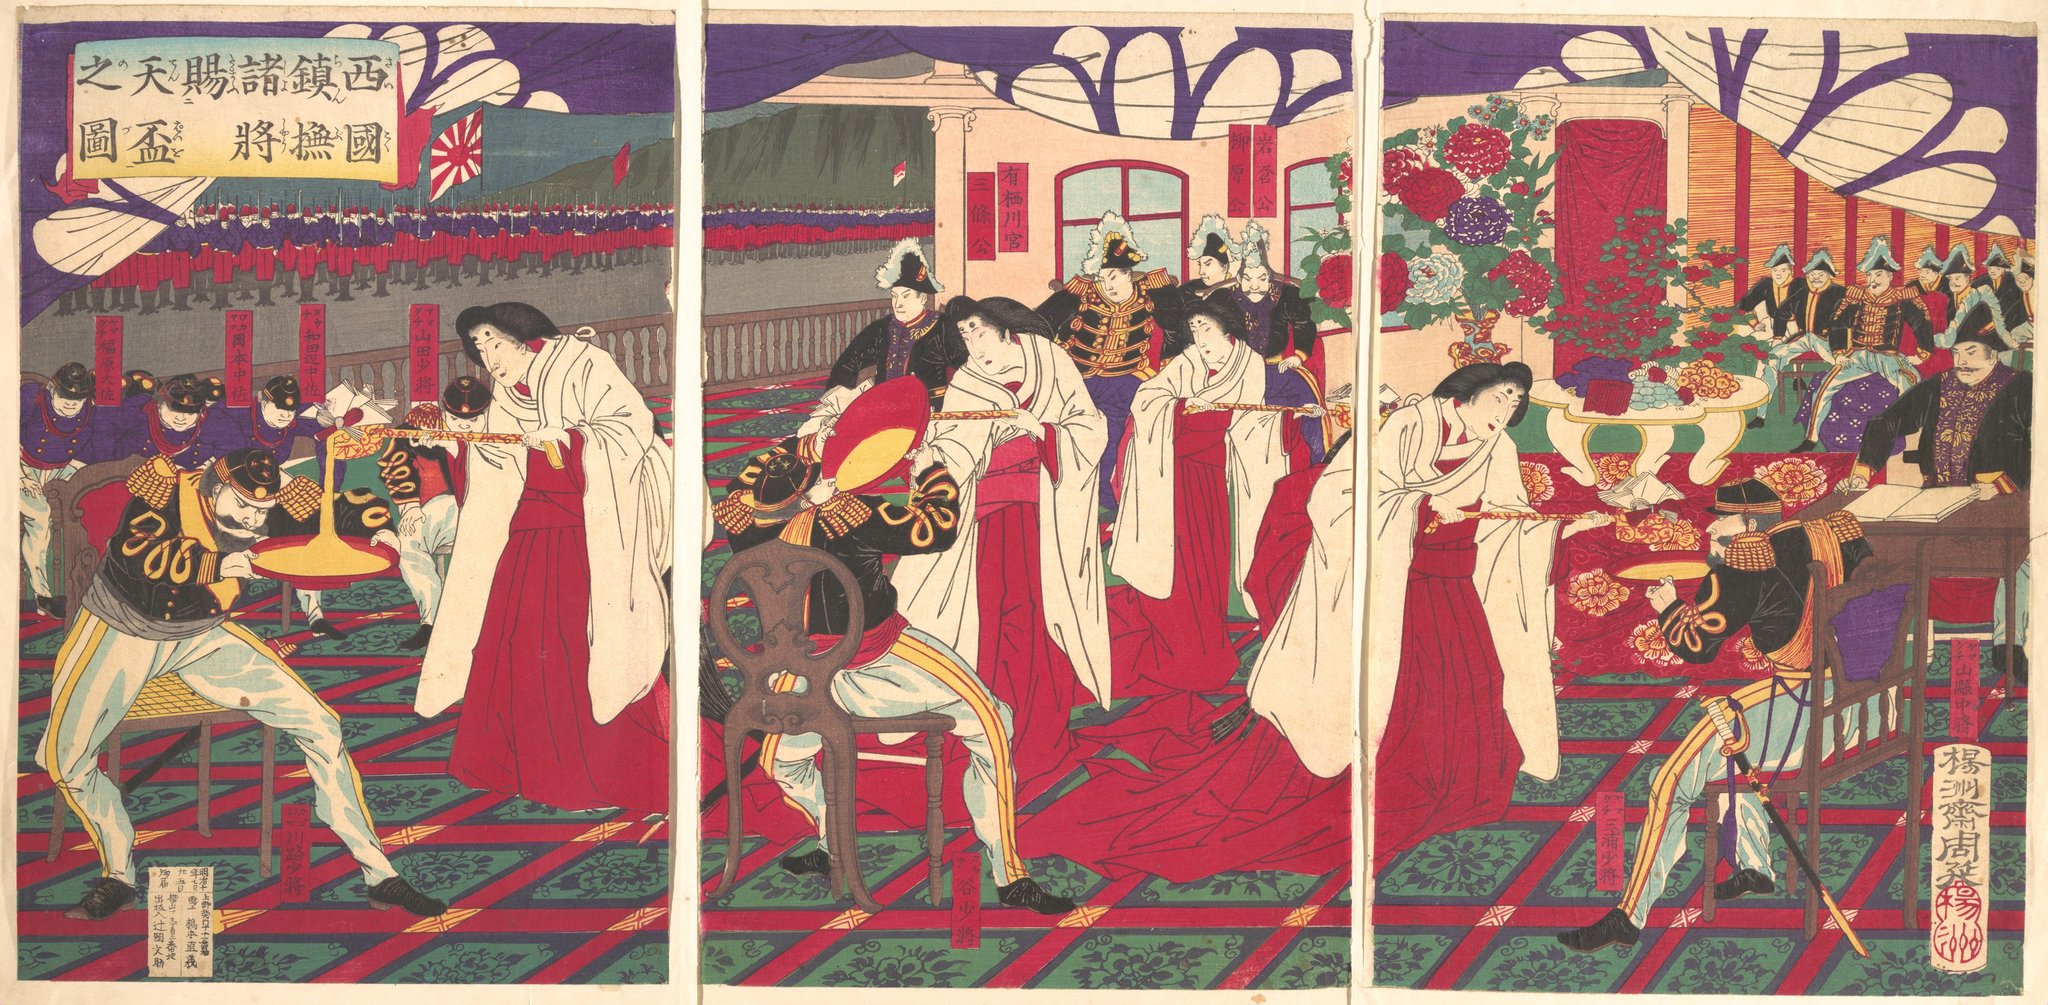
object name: woodblock print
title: Illustration of the Commanders who Pacified Western Japan, Receiving the Emperor's Gift Cups (Saigoku chinbu shoshō tenpai o tamau no zu)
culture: japanese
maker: yōshū (hashimoto) chikanobu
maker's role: artist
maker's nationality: japanese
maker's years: 1838-1912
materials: ink, paper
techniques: woodblock print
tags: soldiers,men,women,flowers,flags